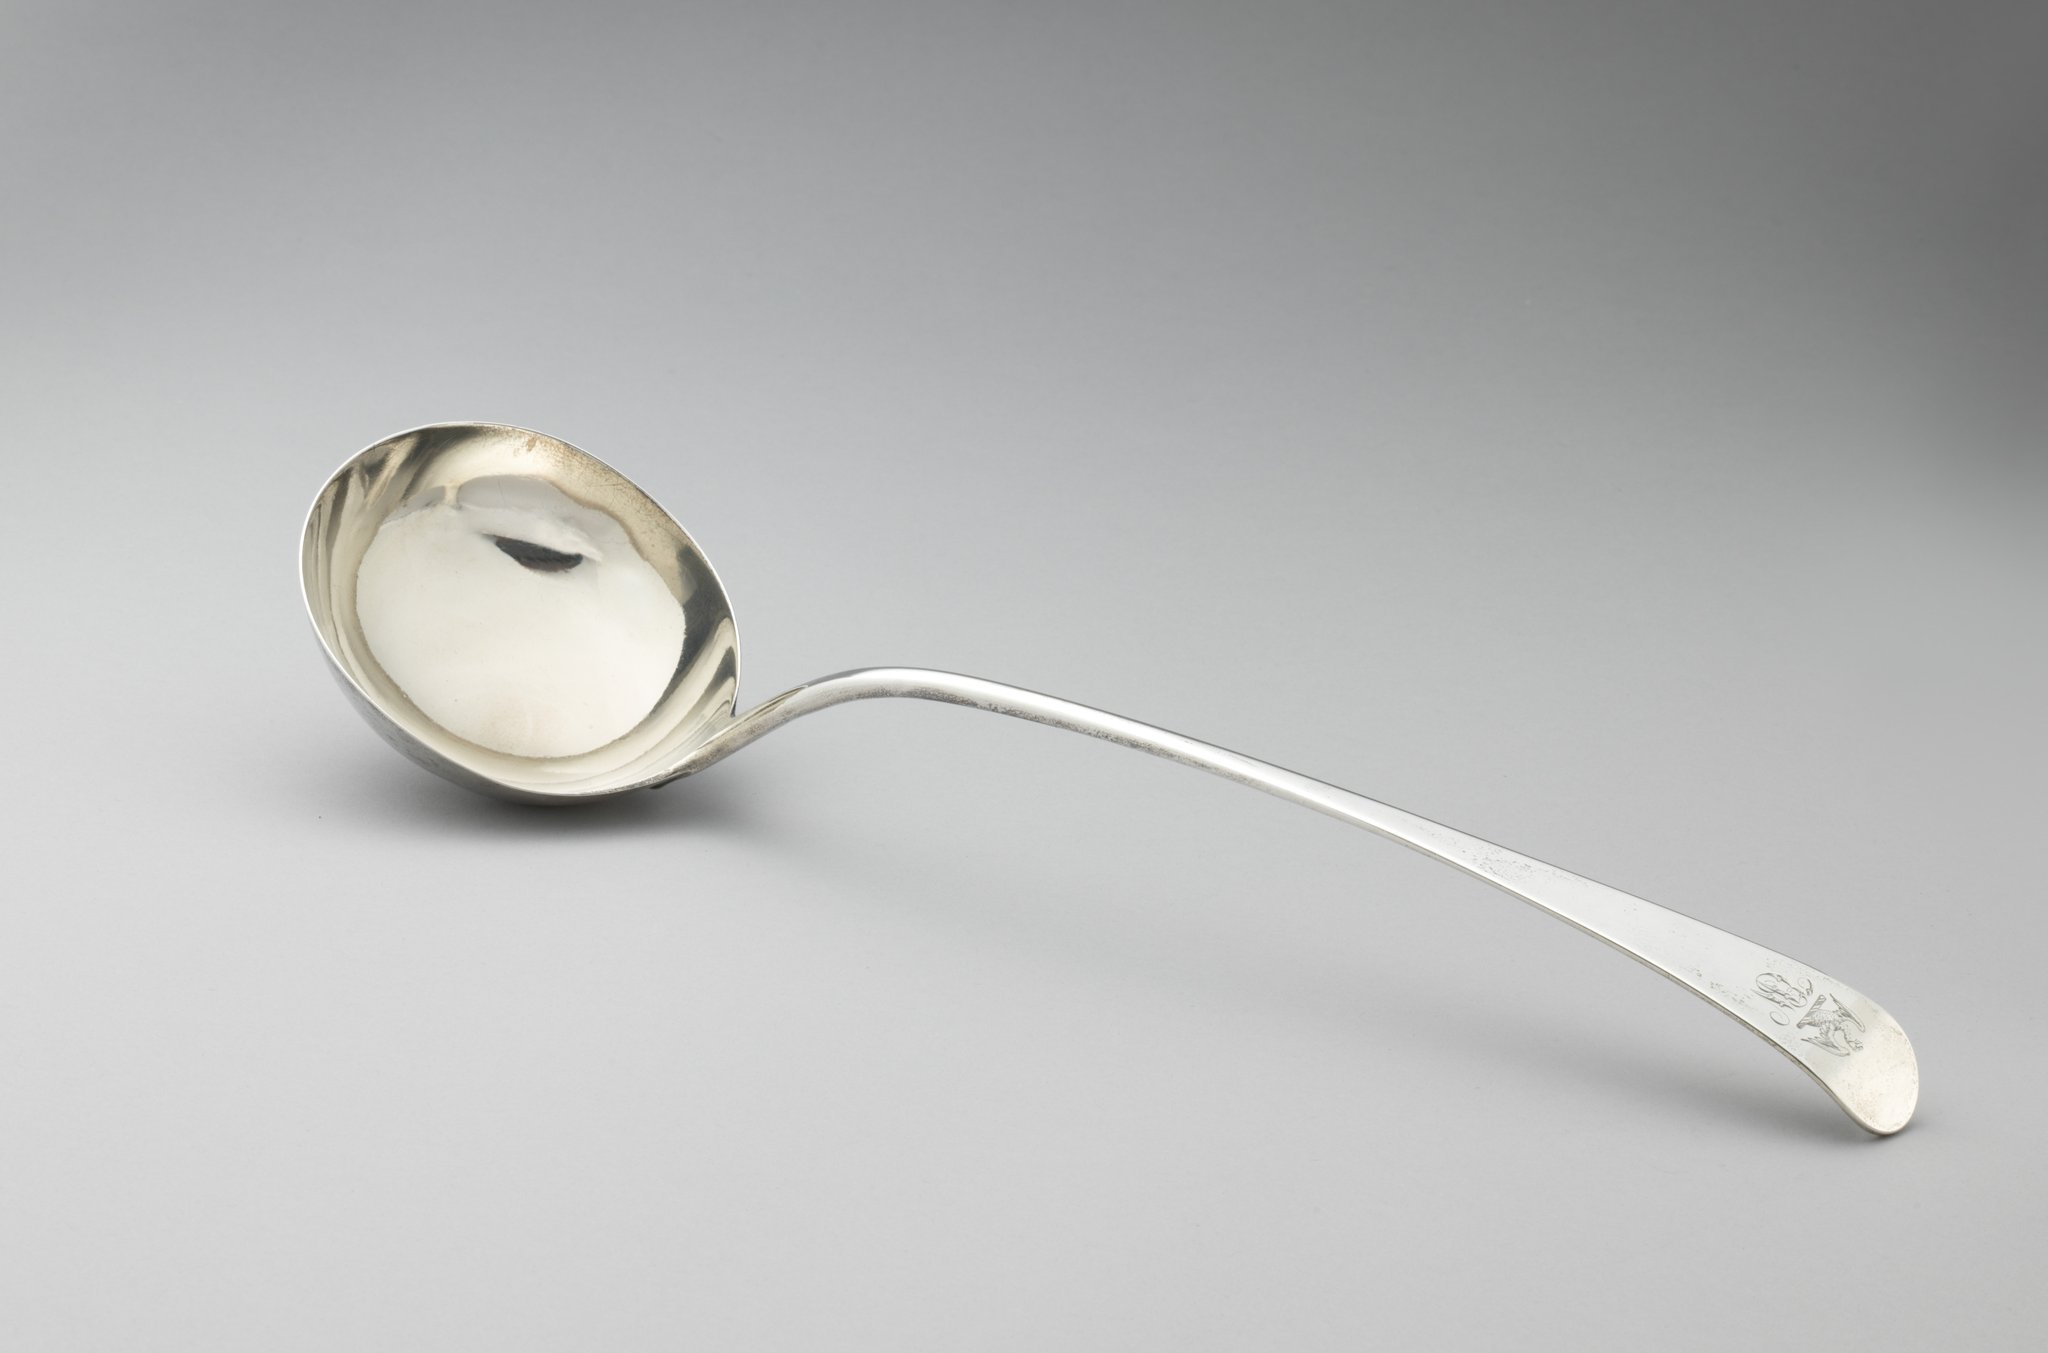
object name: ladle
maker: hester bateman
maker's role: maker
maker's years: 1761-1790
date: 1780-1781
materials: silver